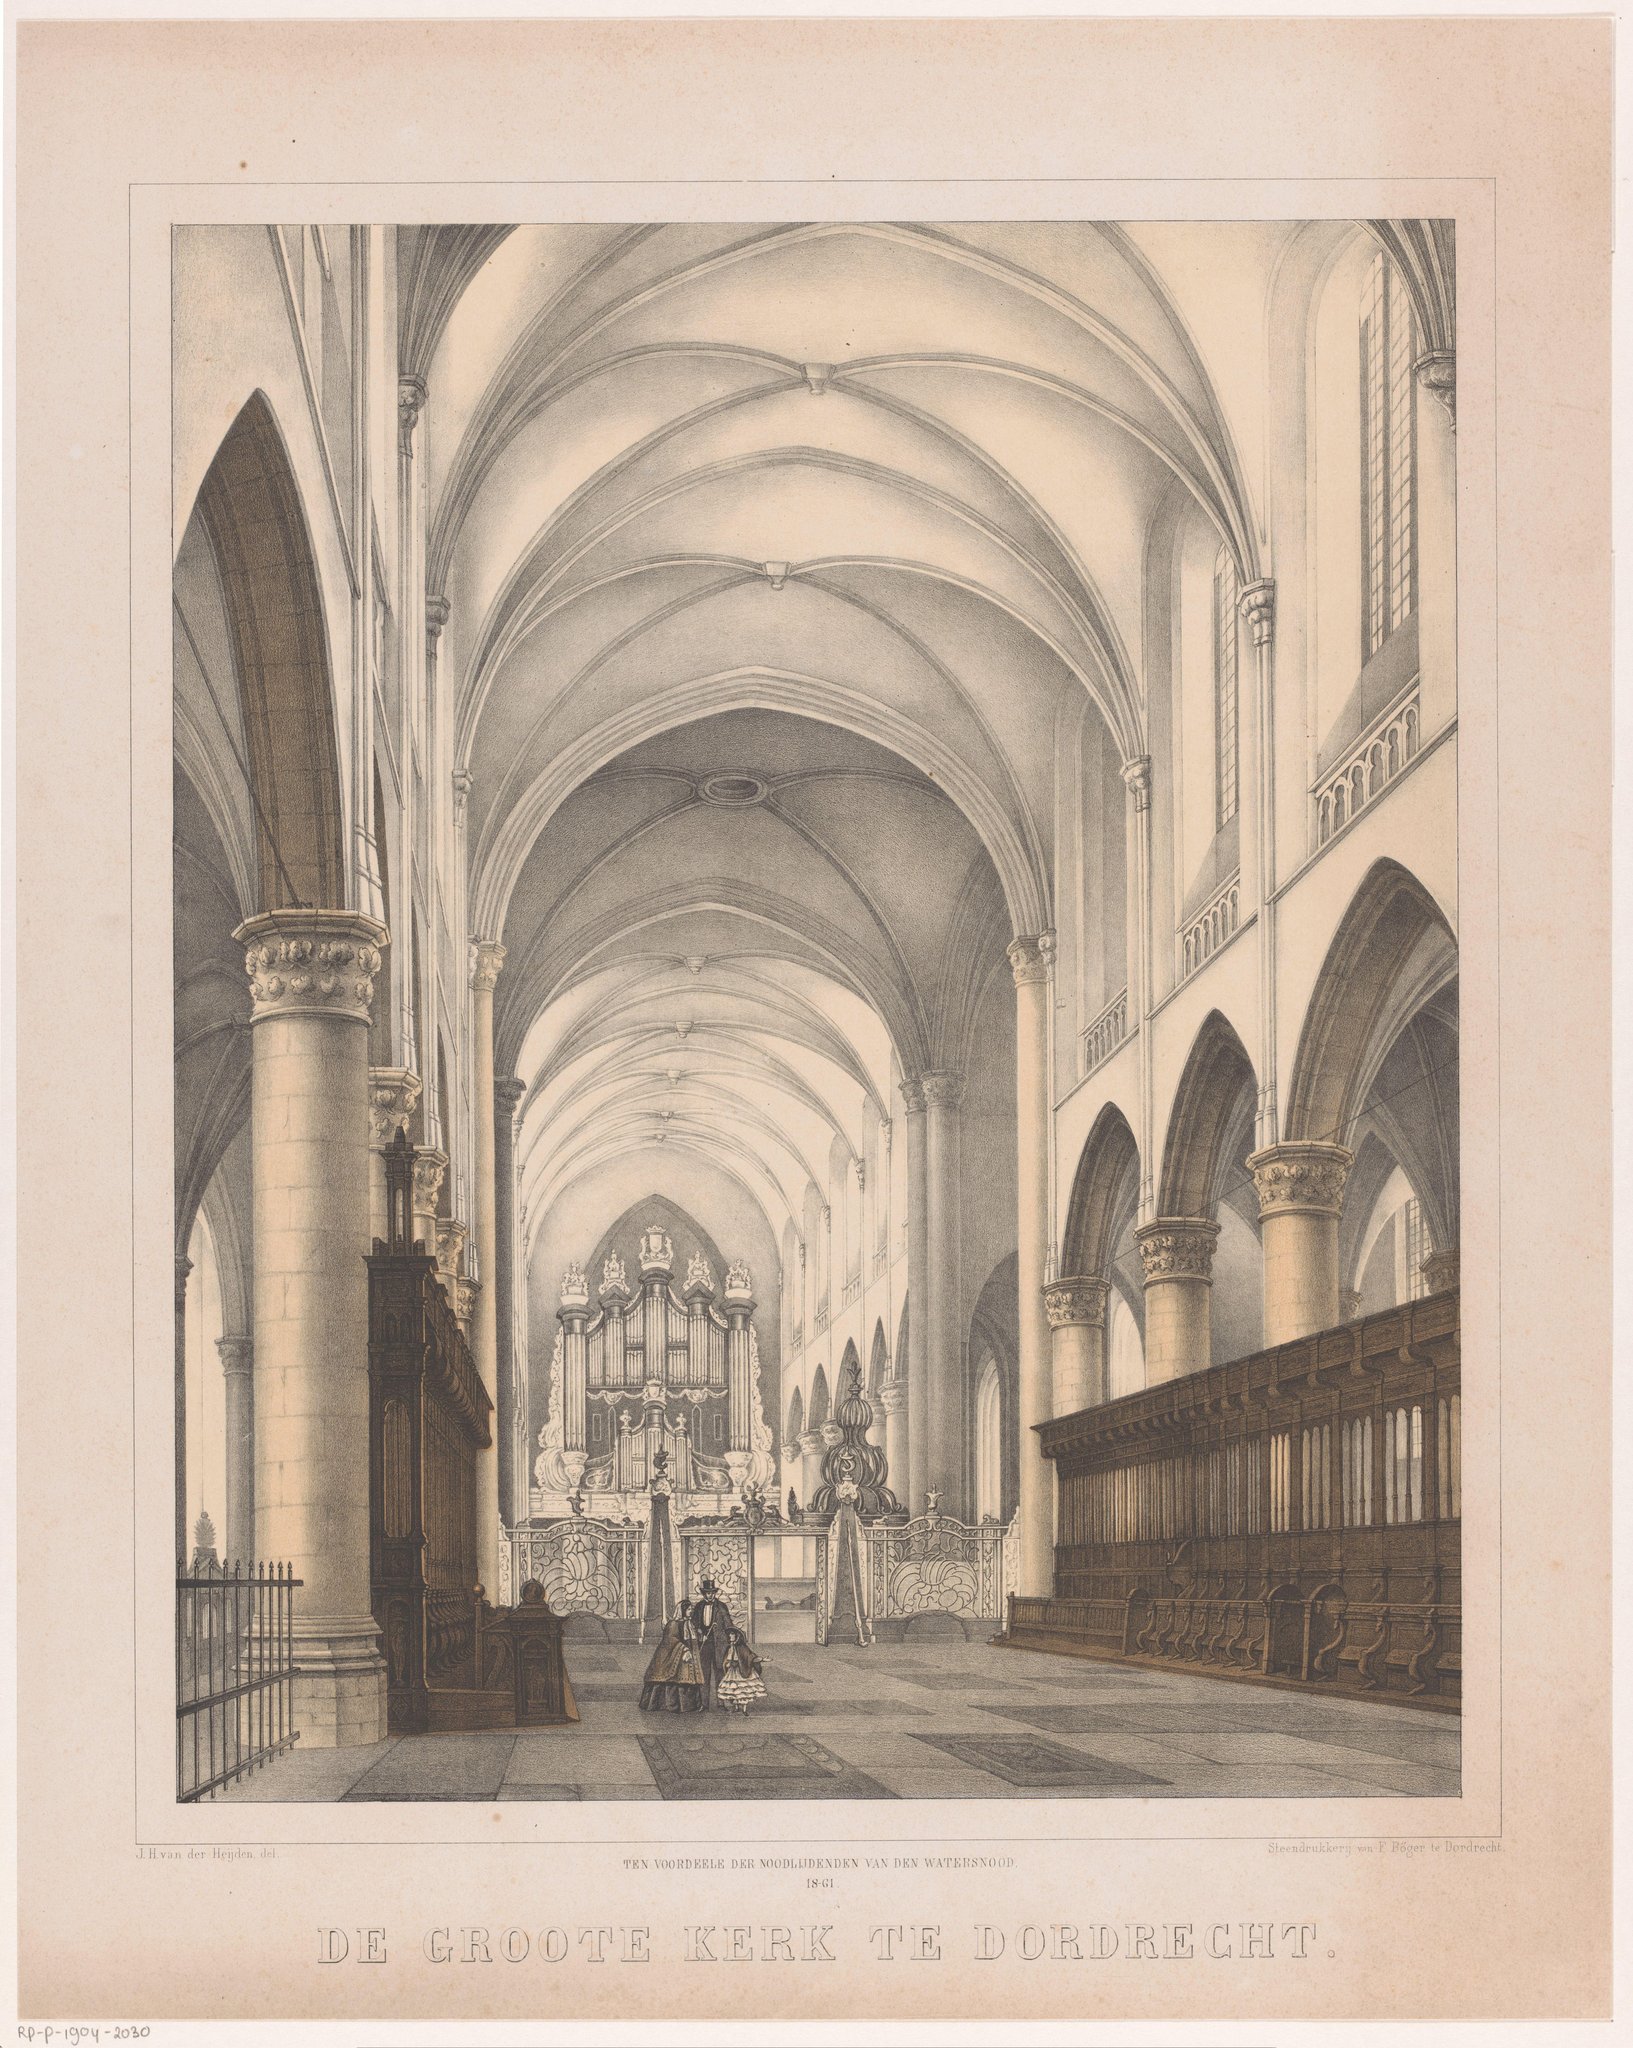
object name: print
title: Interieur van de Grote Kerk in Dordrecht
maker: johannes hermanus van der heijden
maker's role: print maker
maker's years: 1825-1907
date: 1861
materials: paper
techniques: tone lithography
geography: netherlands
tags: church organ, interior of church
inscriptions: collector's mark: Lugt 2228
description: Zicht vanuit het hoogkoor richting de koorhekken, het middenschip en het orgel.